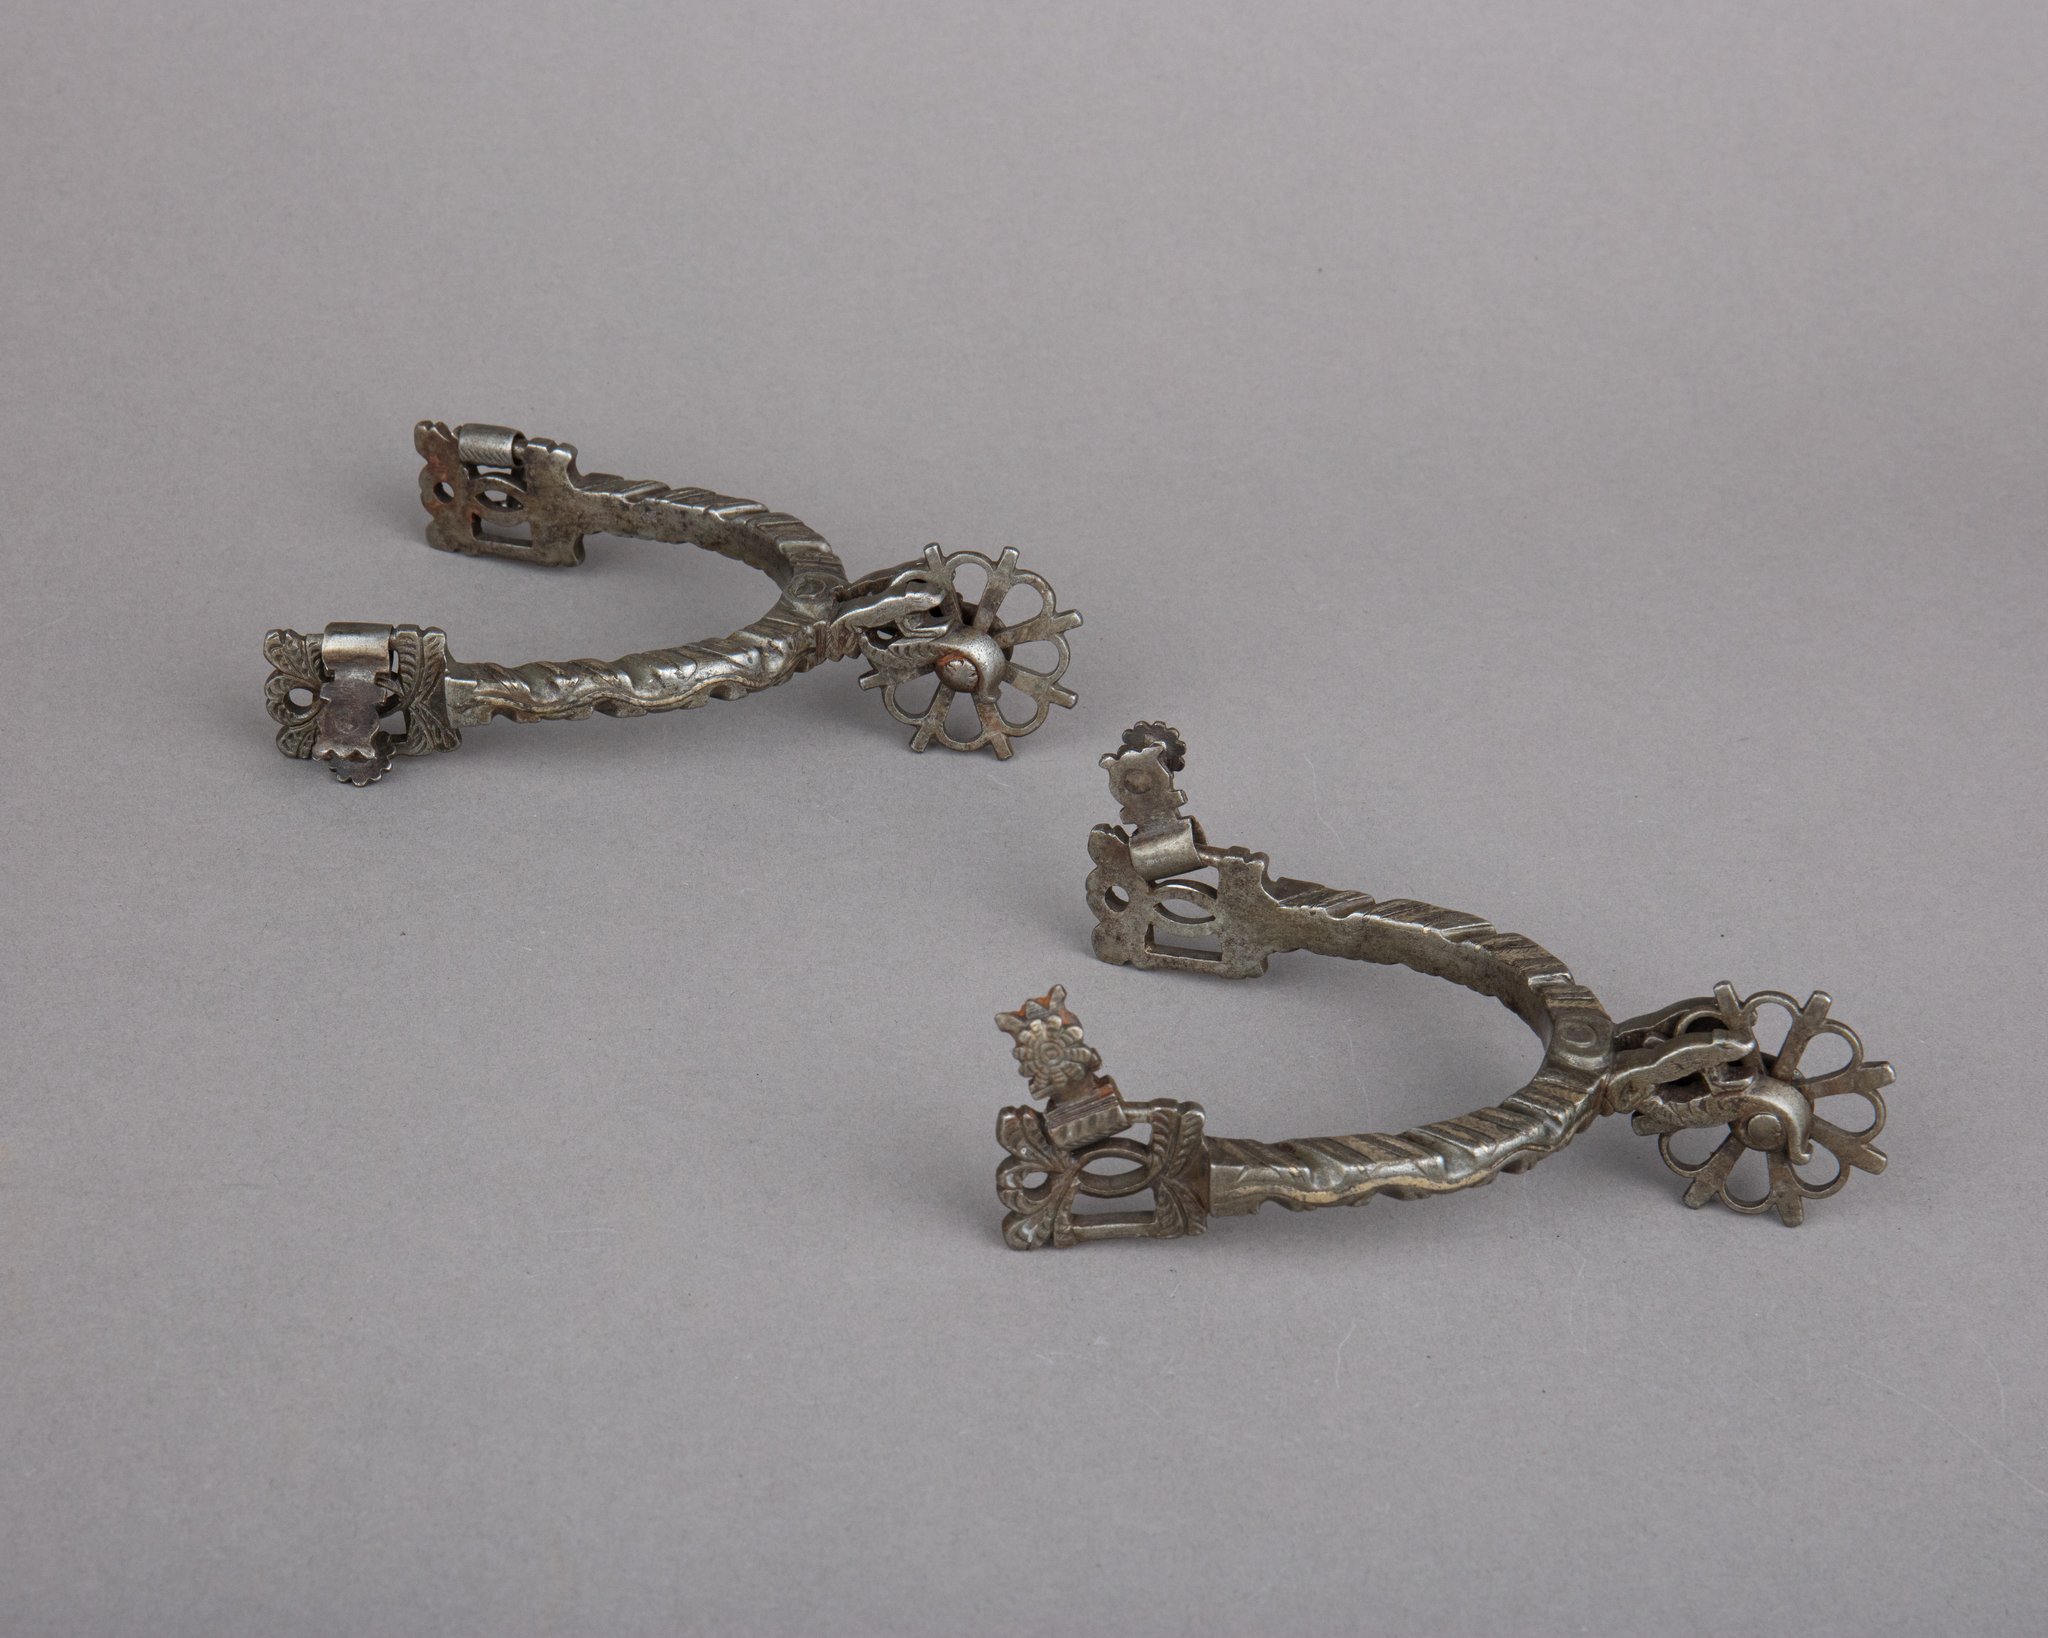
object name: spur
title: Pair of Rowel Spurs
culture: mexican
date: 1701-1800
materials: metal alloy, silver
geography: mexico